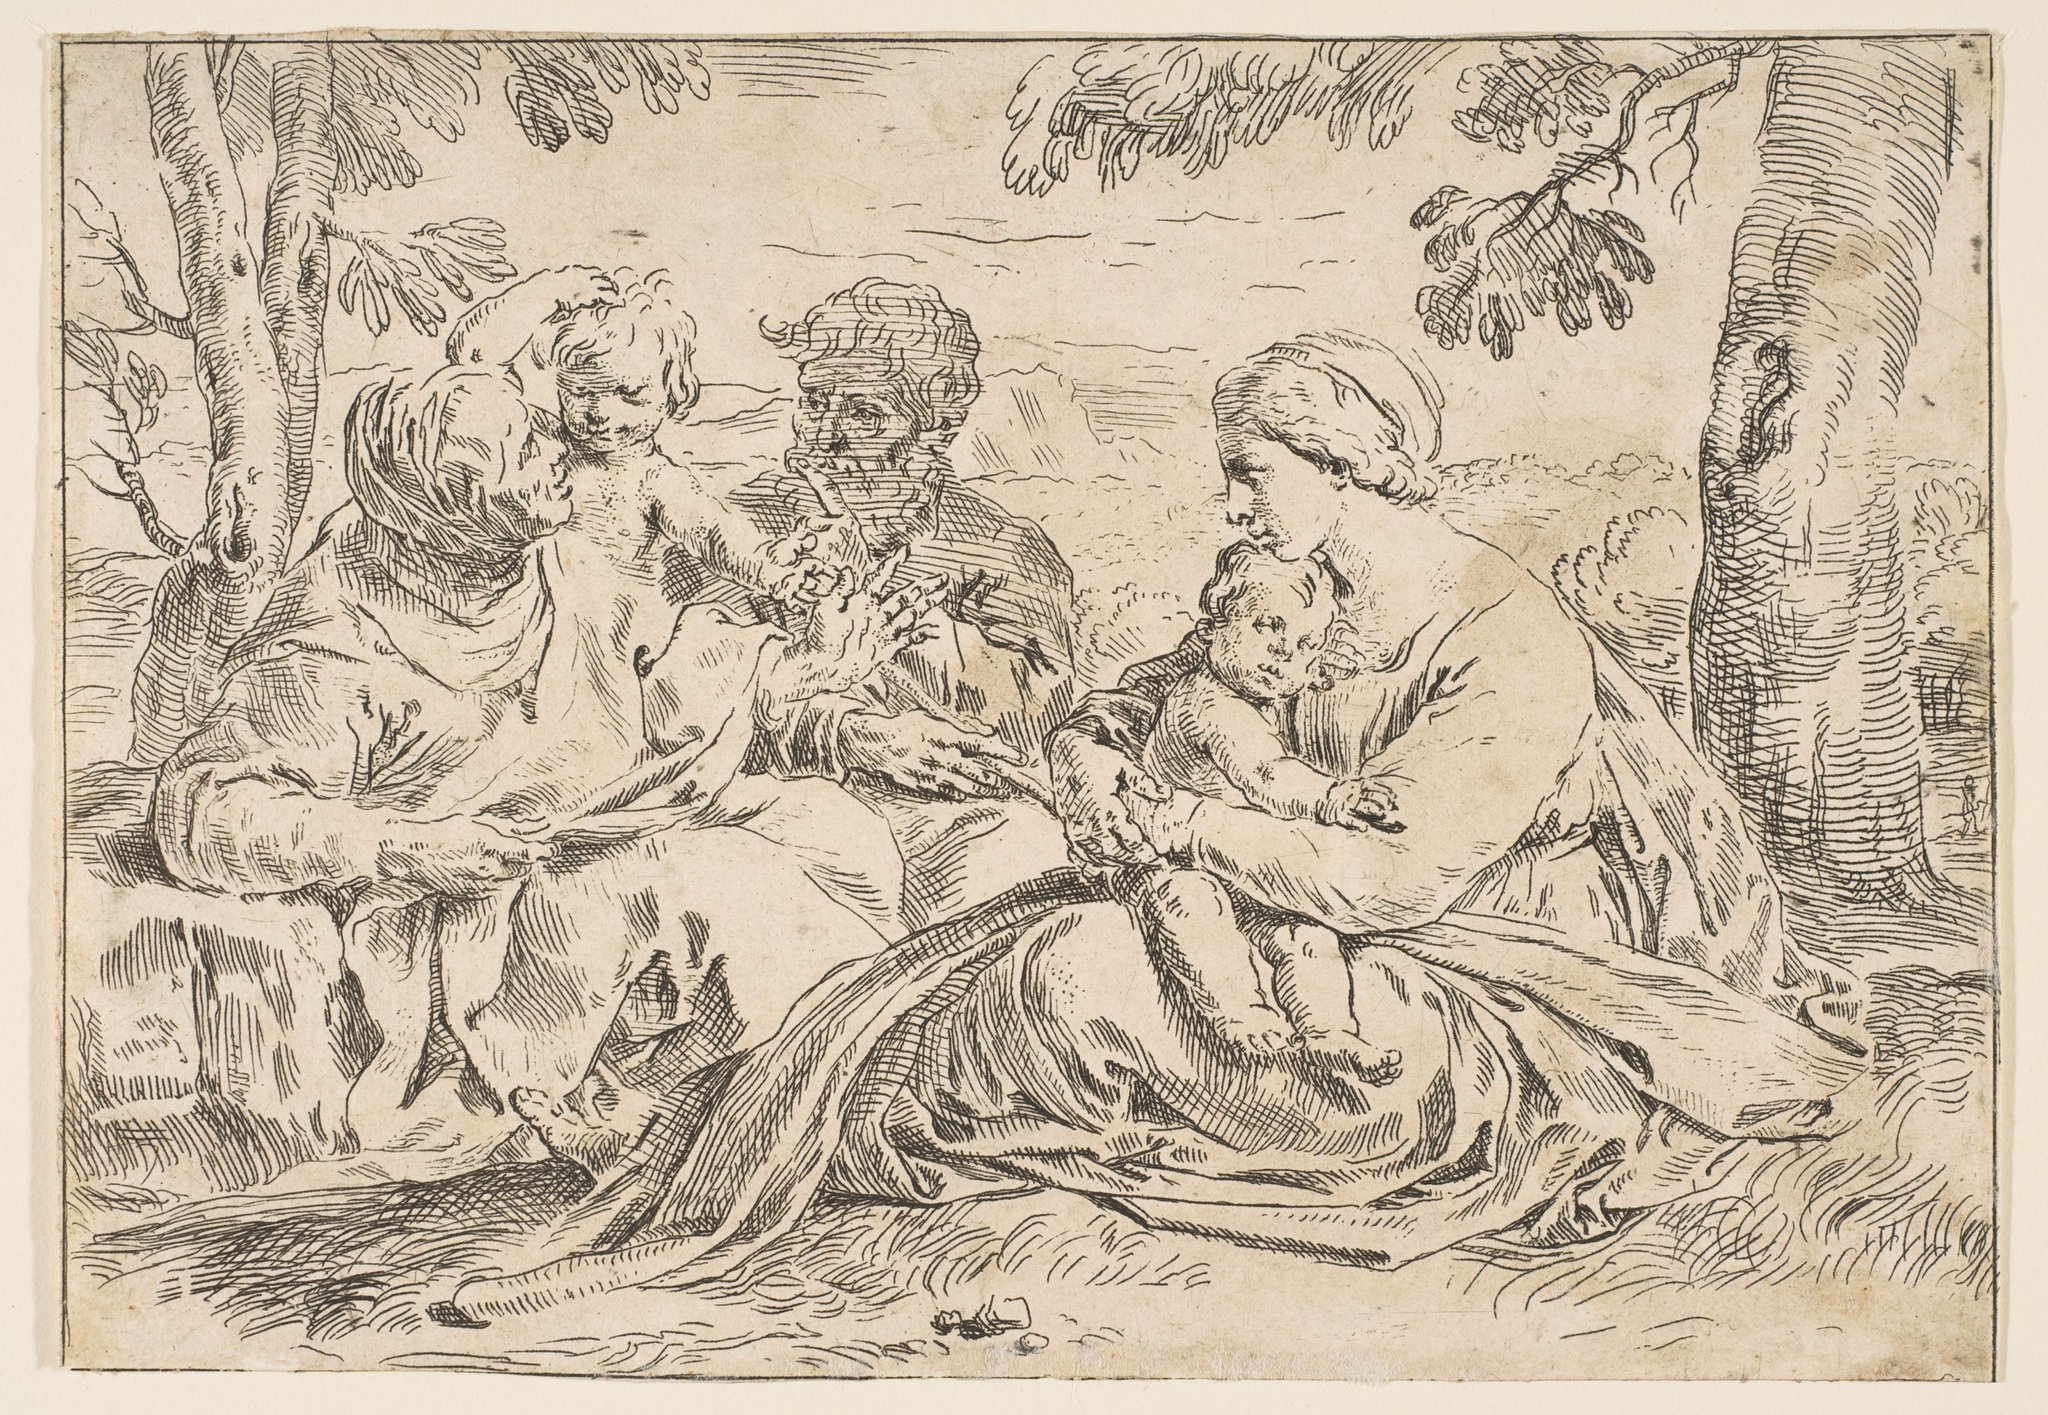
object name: print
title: Holy Family with Saint Elizabeth and Saint John the Baptist, copy in reverse after Cantarini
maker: simone cantarini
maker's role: artist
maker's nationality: italian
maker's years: 1612-1648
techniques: etching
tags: women,holy family,saint john the baptist